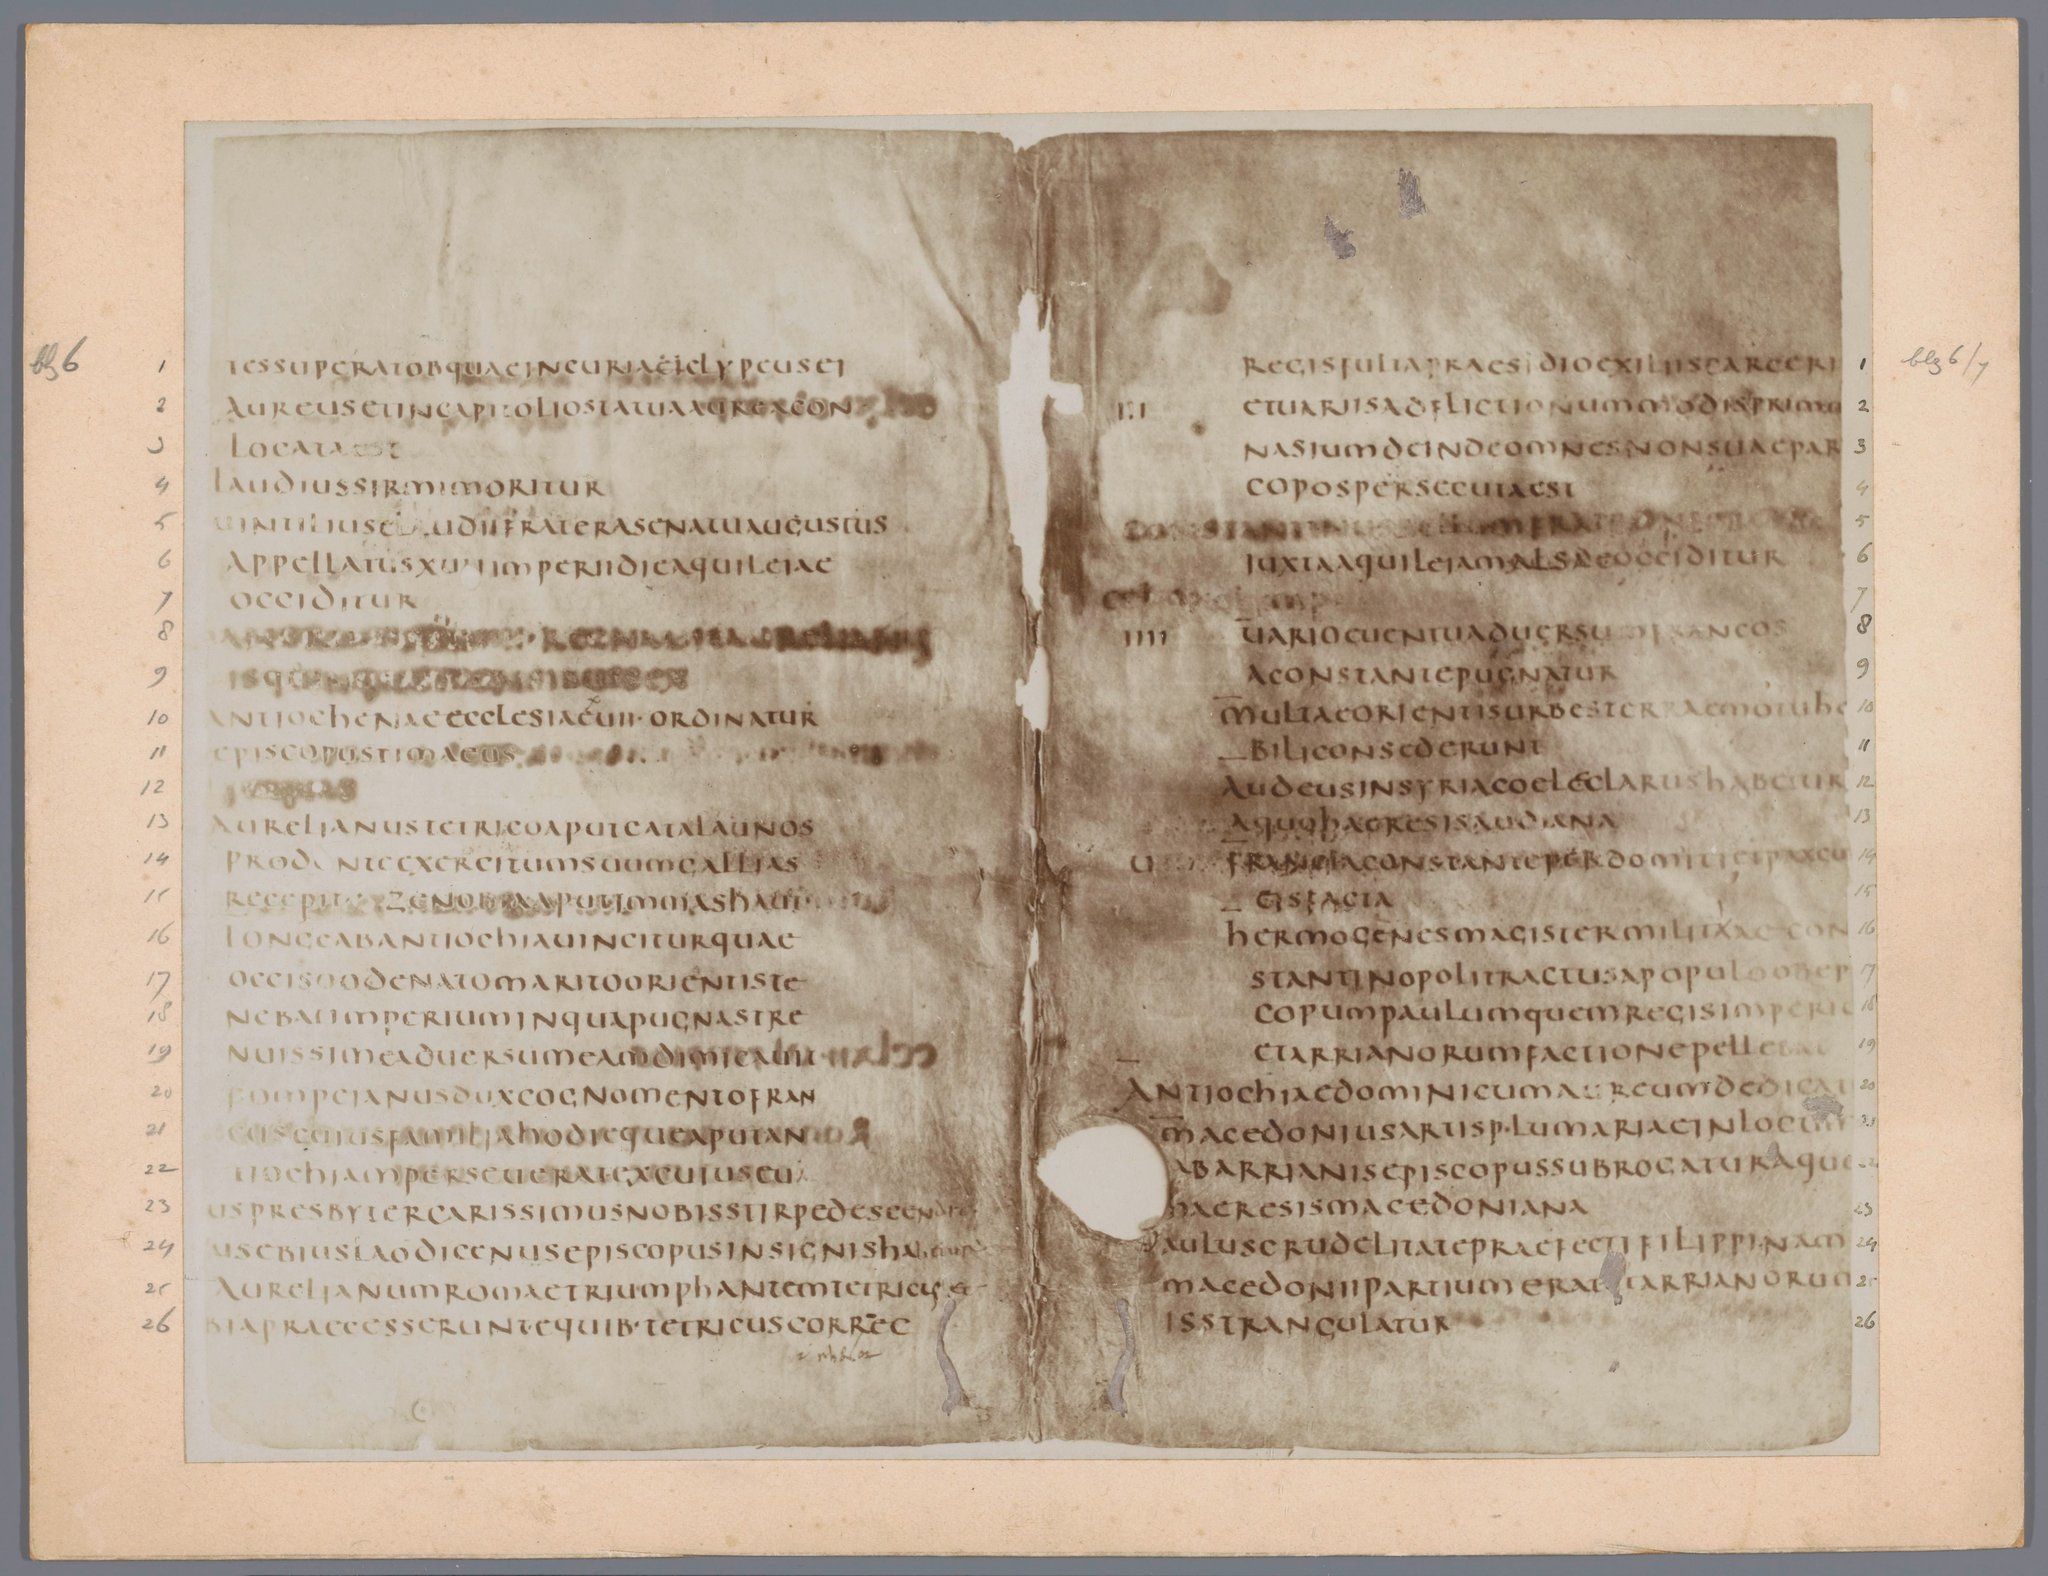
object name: reproduction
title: Pagina uit een manuscript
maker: jan goedeljee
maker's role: fotograaf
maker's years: 1824-1905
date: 1812-1879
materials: cardboard, paper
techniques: collodion silver print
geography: leiden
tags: handwriting, written text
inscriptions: label: ‘J.GOEDELJEE/ Hofphotograph/ LEIDEN’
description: Fotoreproductie van een pagina uit een manuscript op perkament.